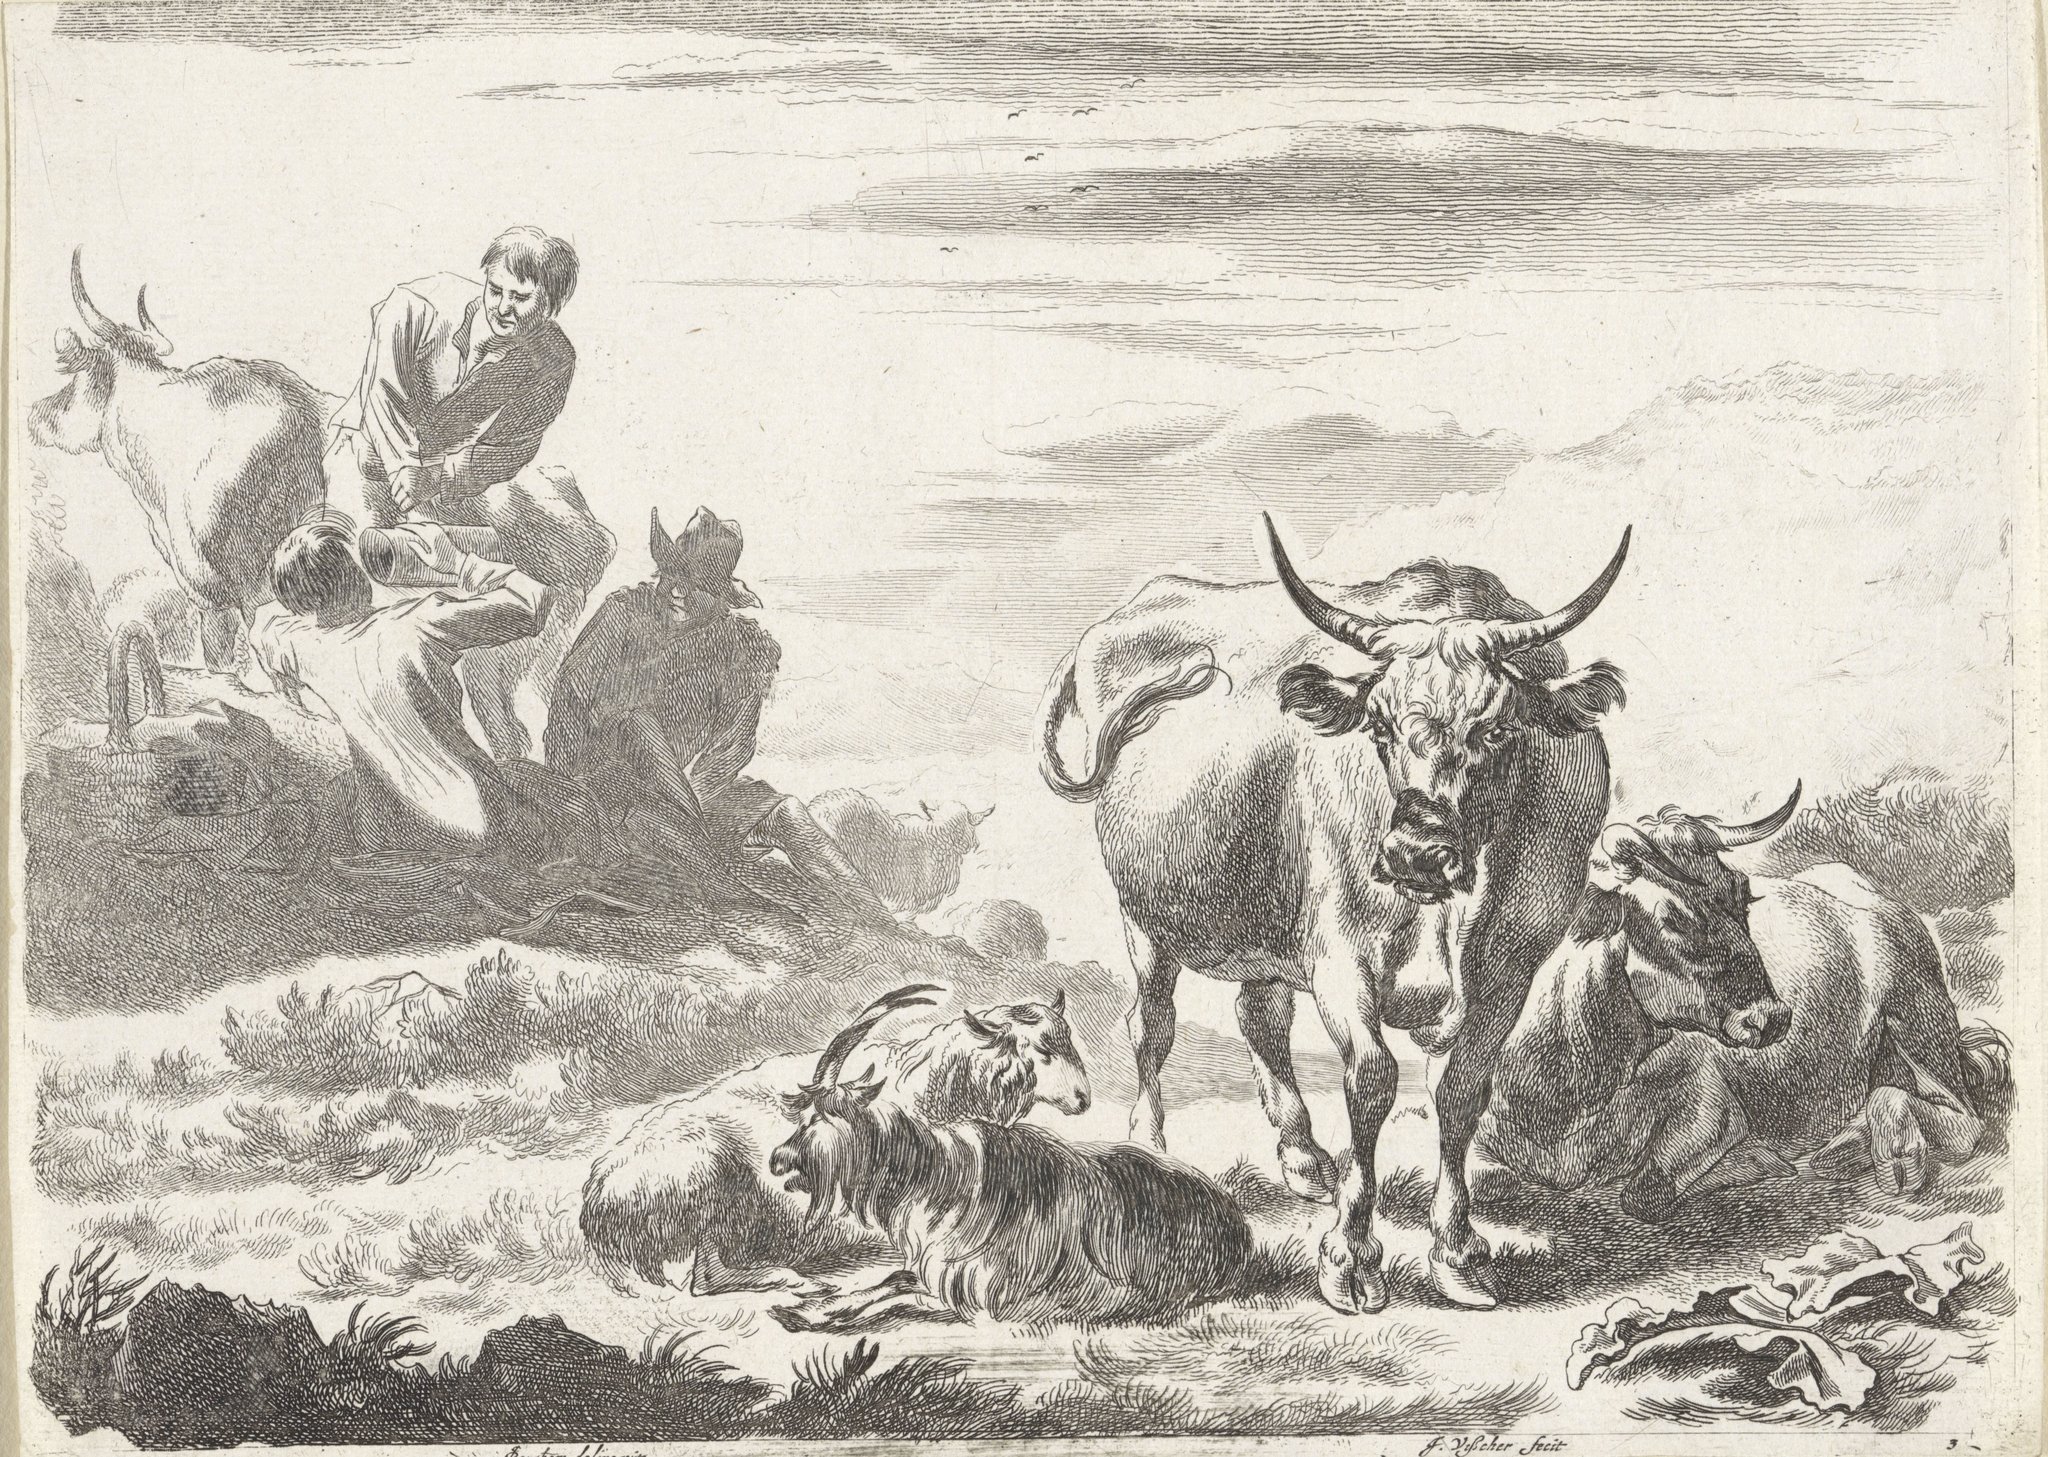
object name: print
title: Herders tussen hun kudde aan een maaltijd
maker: jan de visscher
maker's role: print maker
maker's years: 1633-1712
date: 1643-1706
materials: paper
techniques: engraving, etching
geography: northern netherlands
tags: cow, herding, herdsman, herdswoman, shepherd, shepherdess, cowherd, etc., midday meal, lunch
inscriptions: collector's mark: Lugt 240